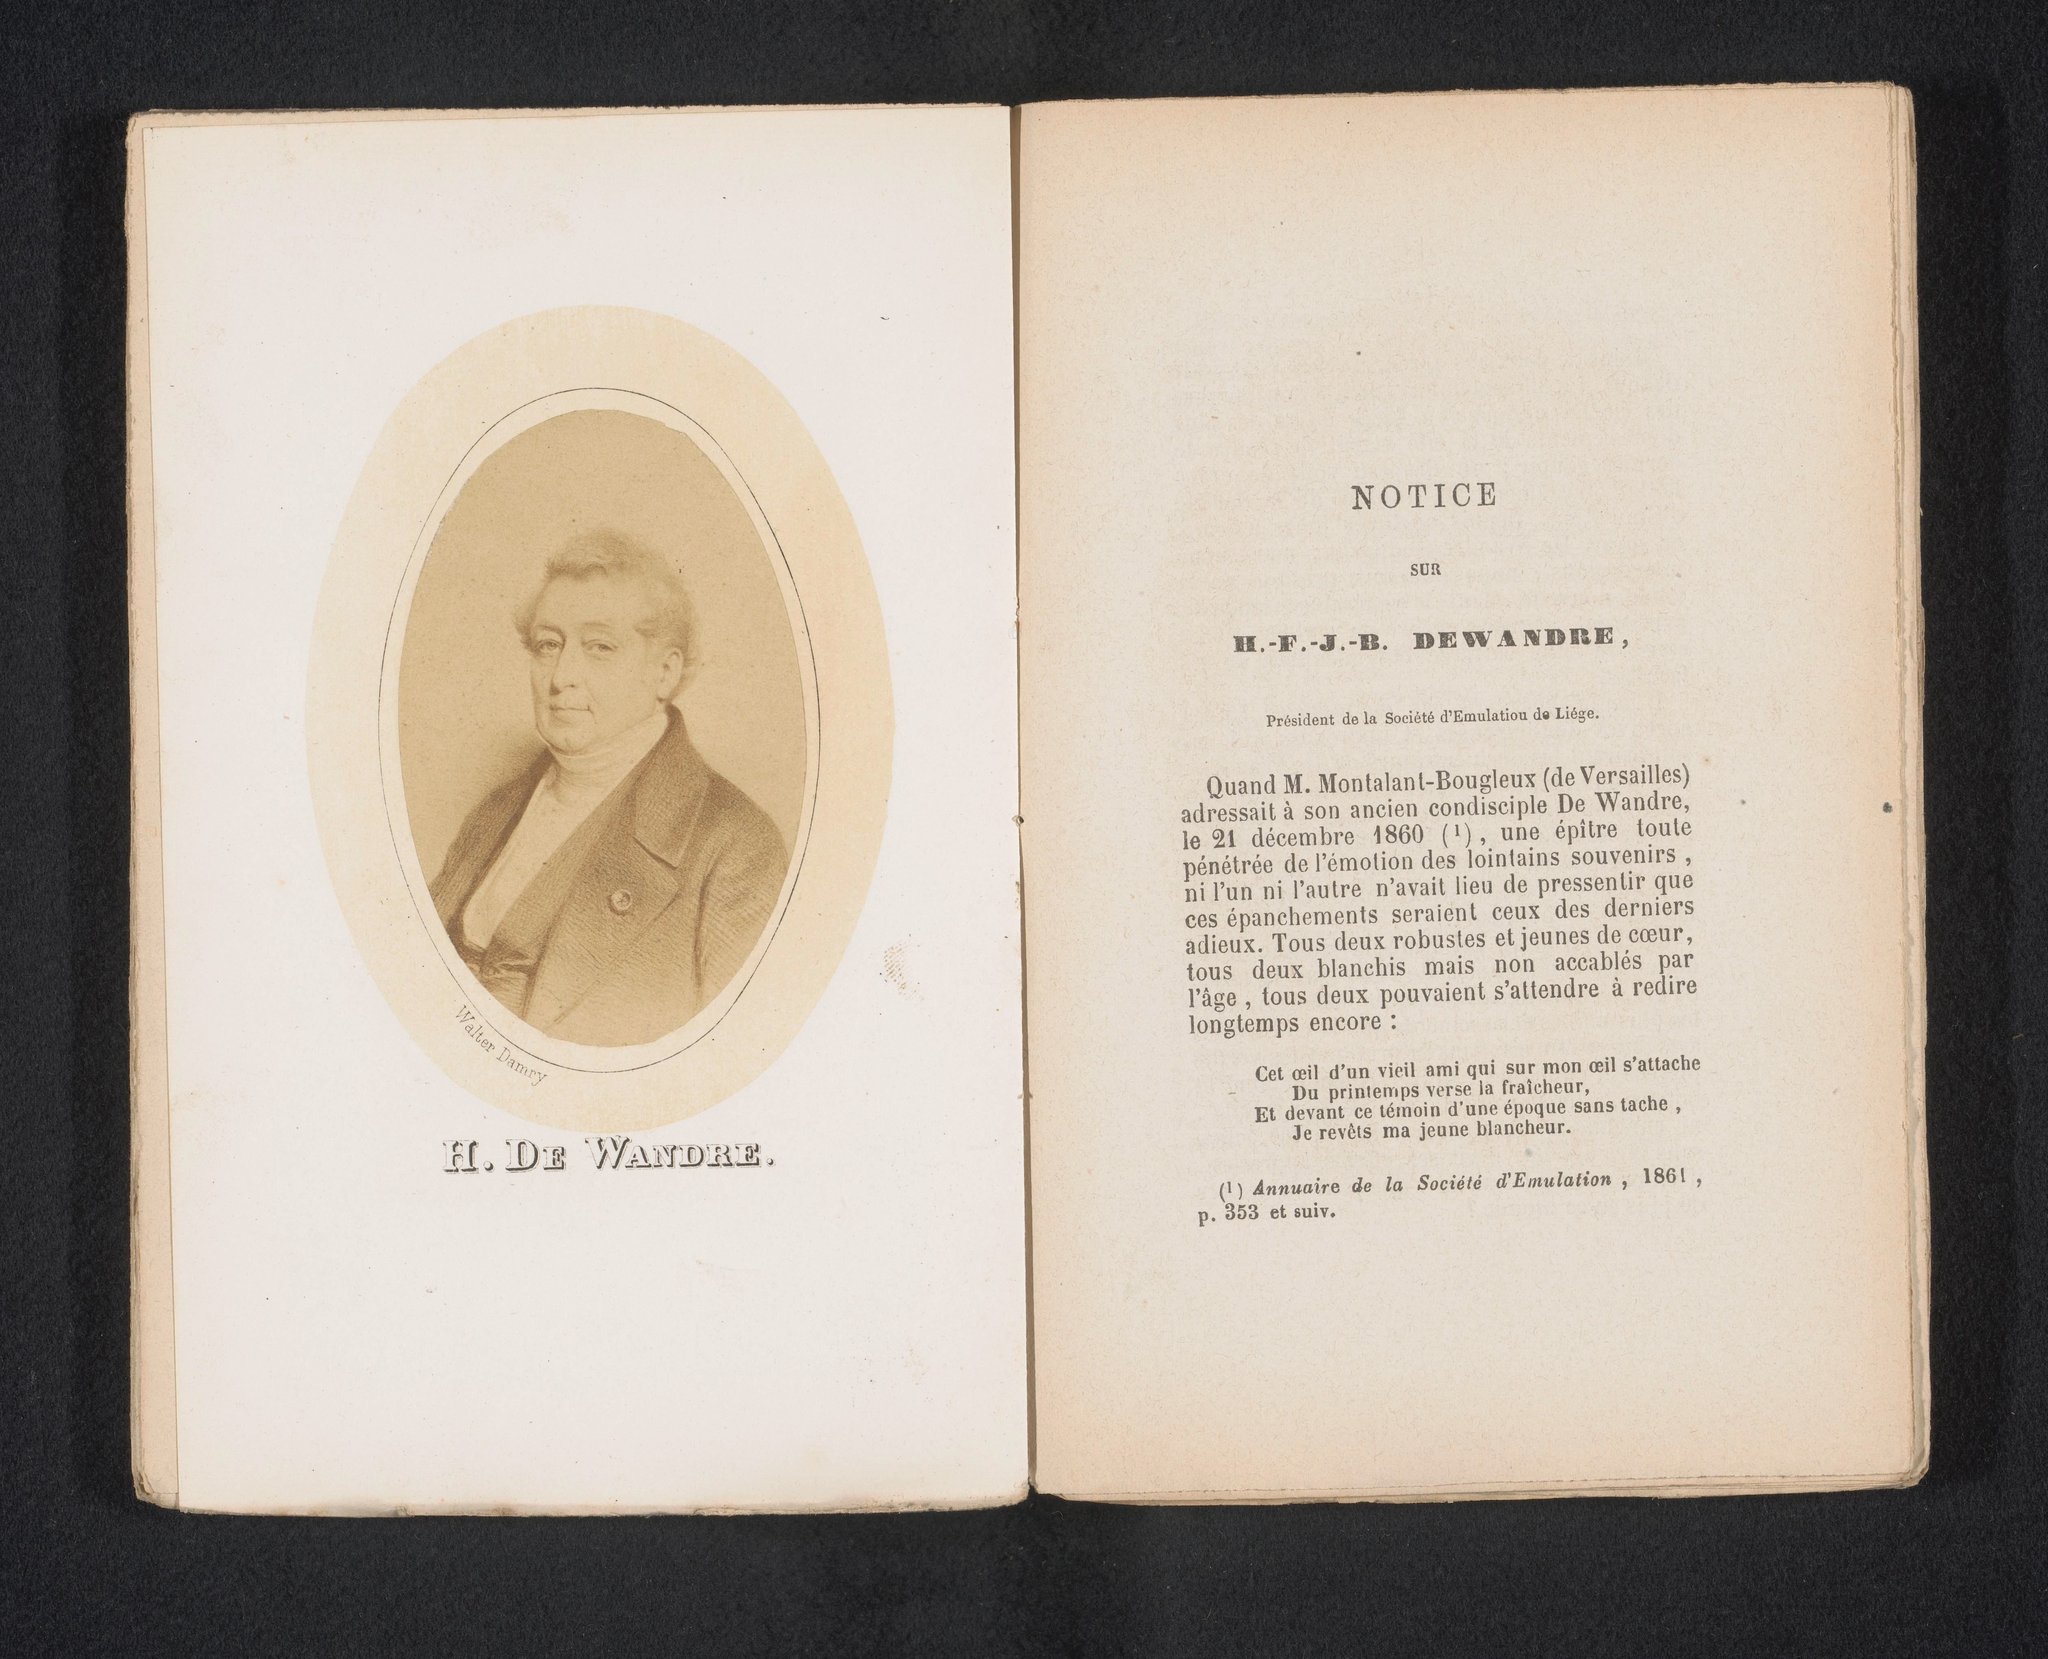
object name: photograph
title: Portret van Henri Dewandre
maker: walter damry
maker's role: fotograaf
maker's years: 1833-1890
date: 1850-1862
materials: photographic support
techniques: albumen print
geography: liège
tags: liège, politician, historical persons